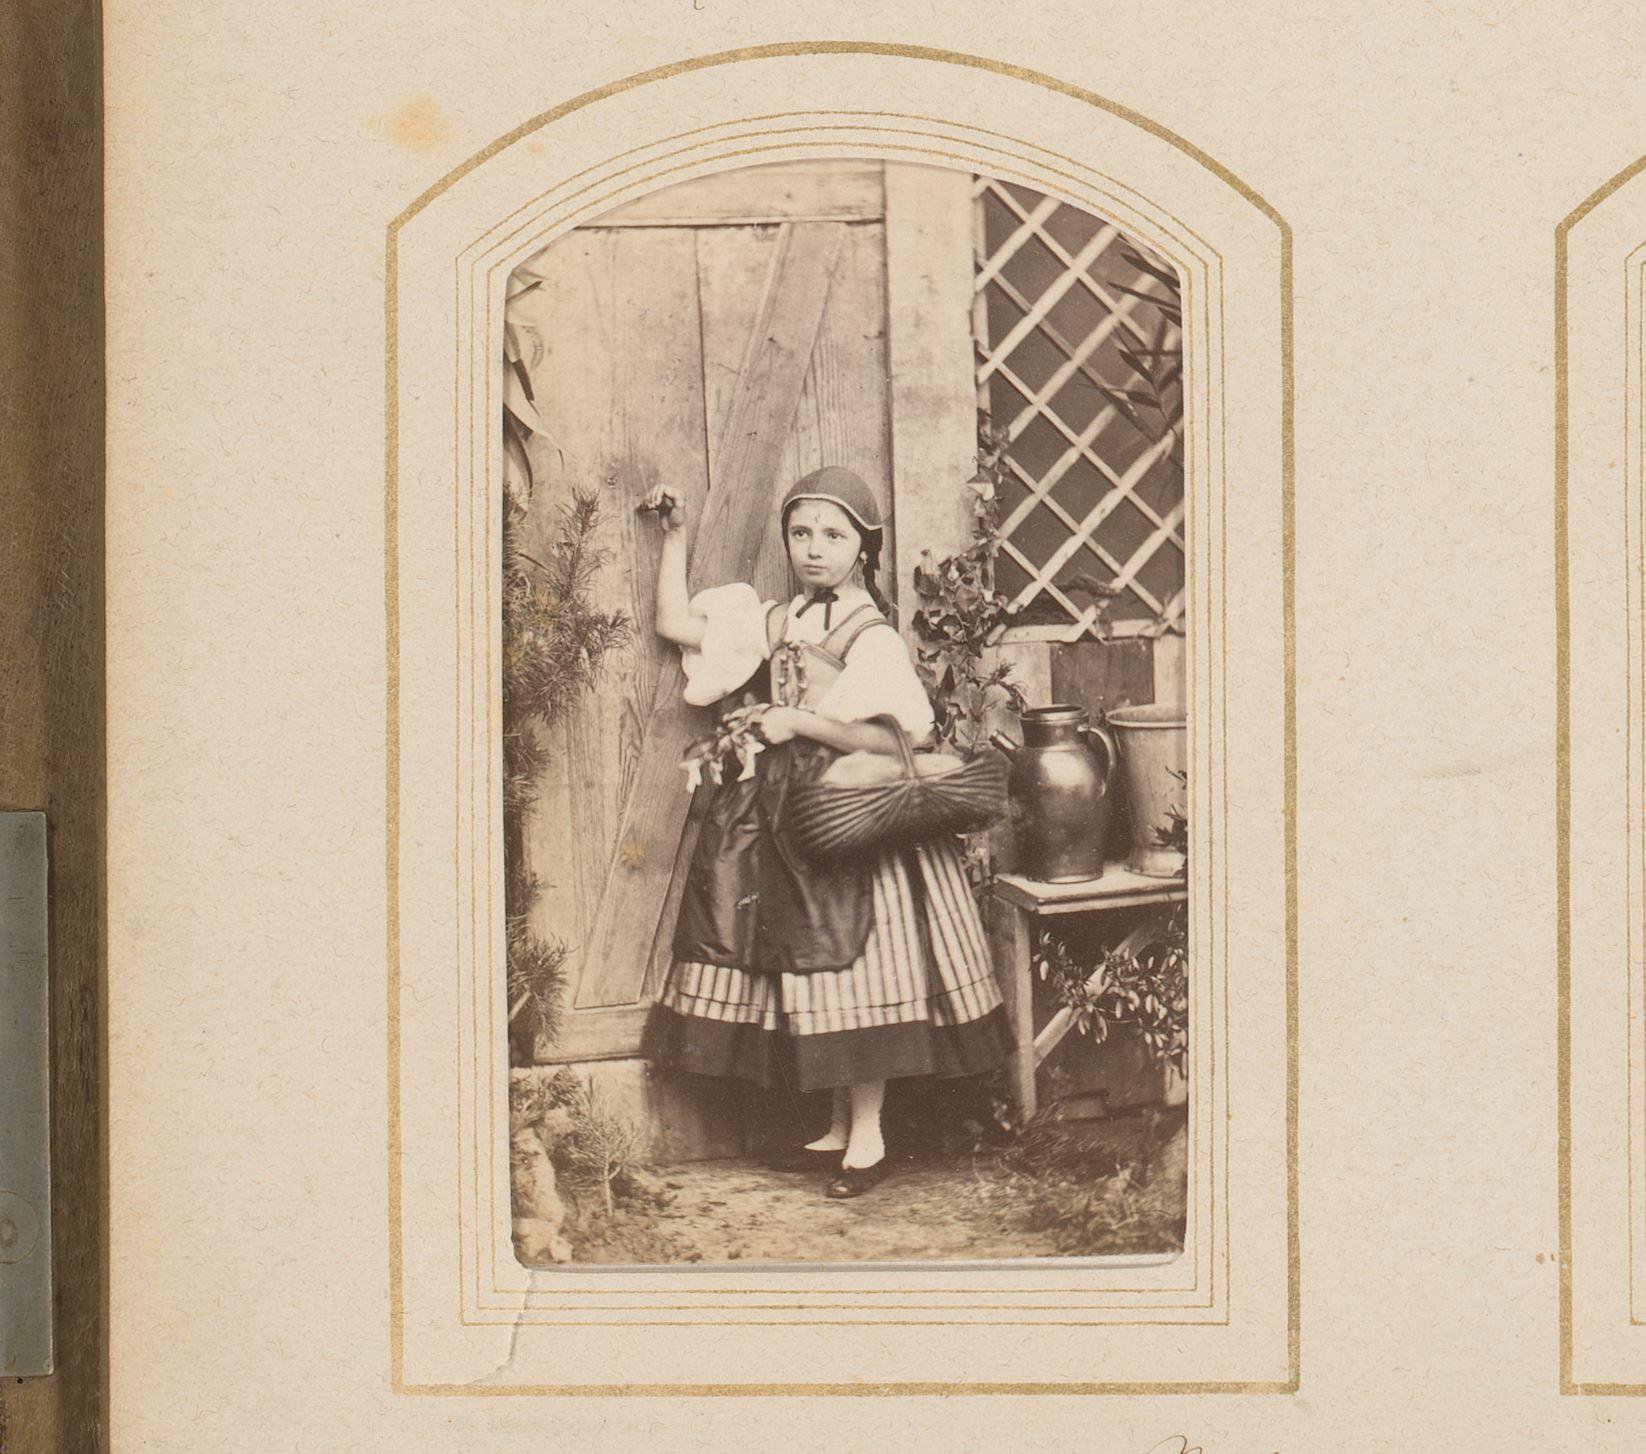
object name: photograph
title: Portret van een meisje verkleed als roodkapje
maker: Anonymous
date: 1870-1890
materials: cardboard, photographic support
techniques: albumen print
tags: girl (child between toddler and youth), tales and fairy tales: little red riding-hood, trade games, imitative games, imitating adults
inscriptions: number: ‘583’, annotation: ‘Rotkäppchen’